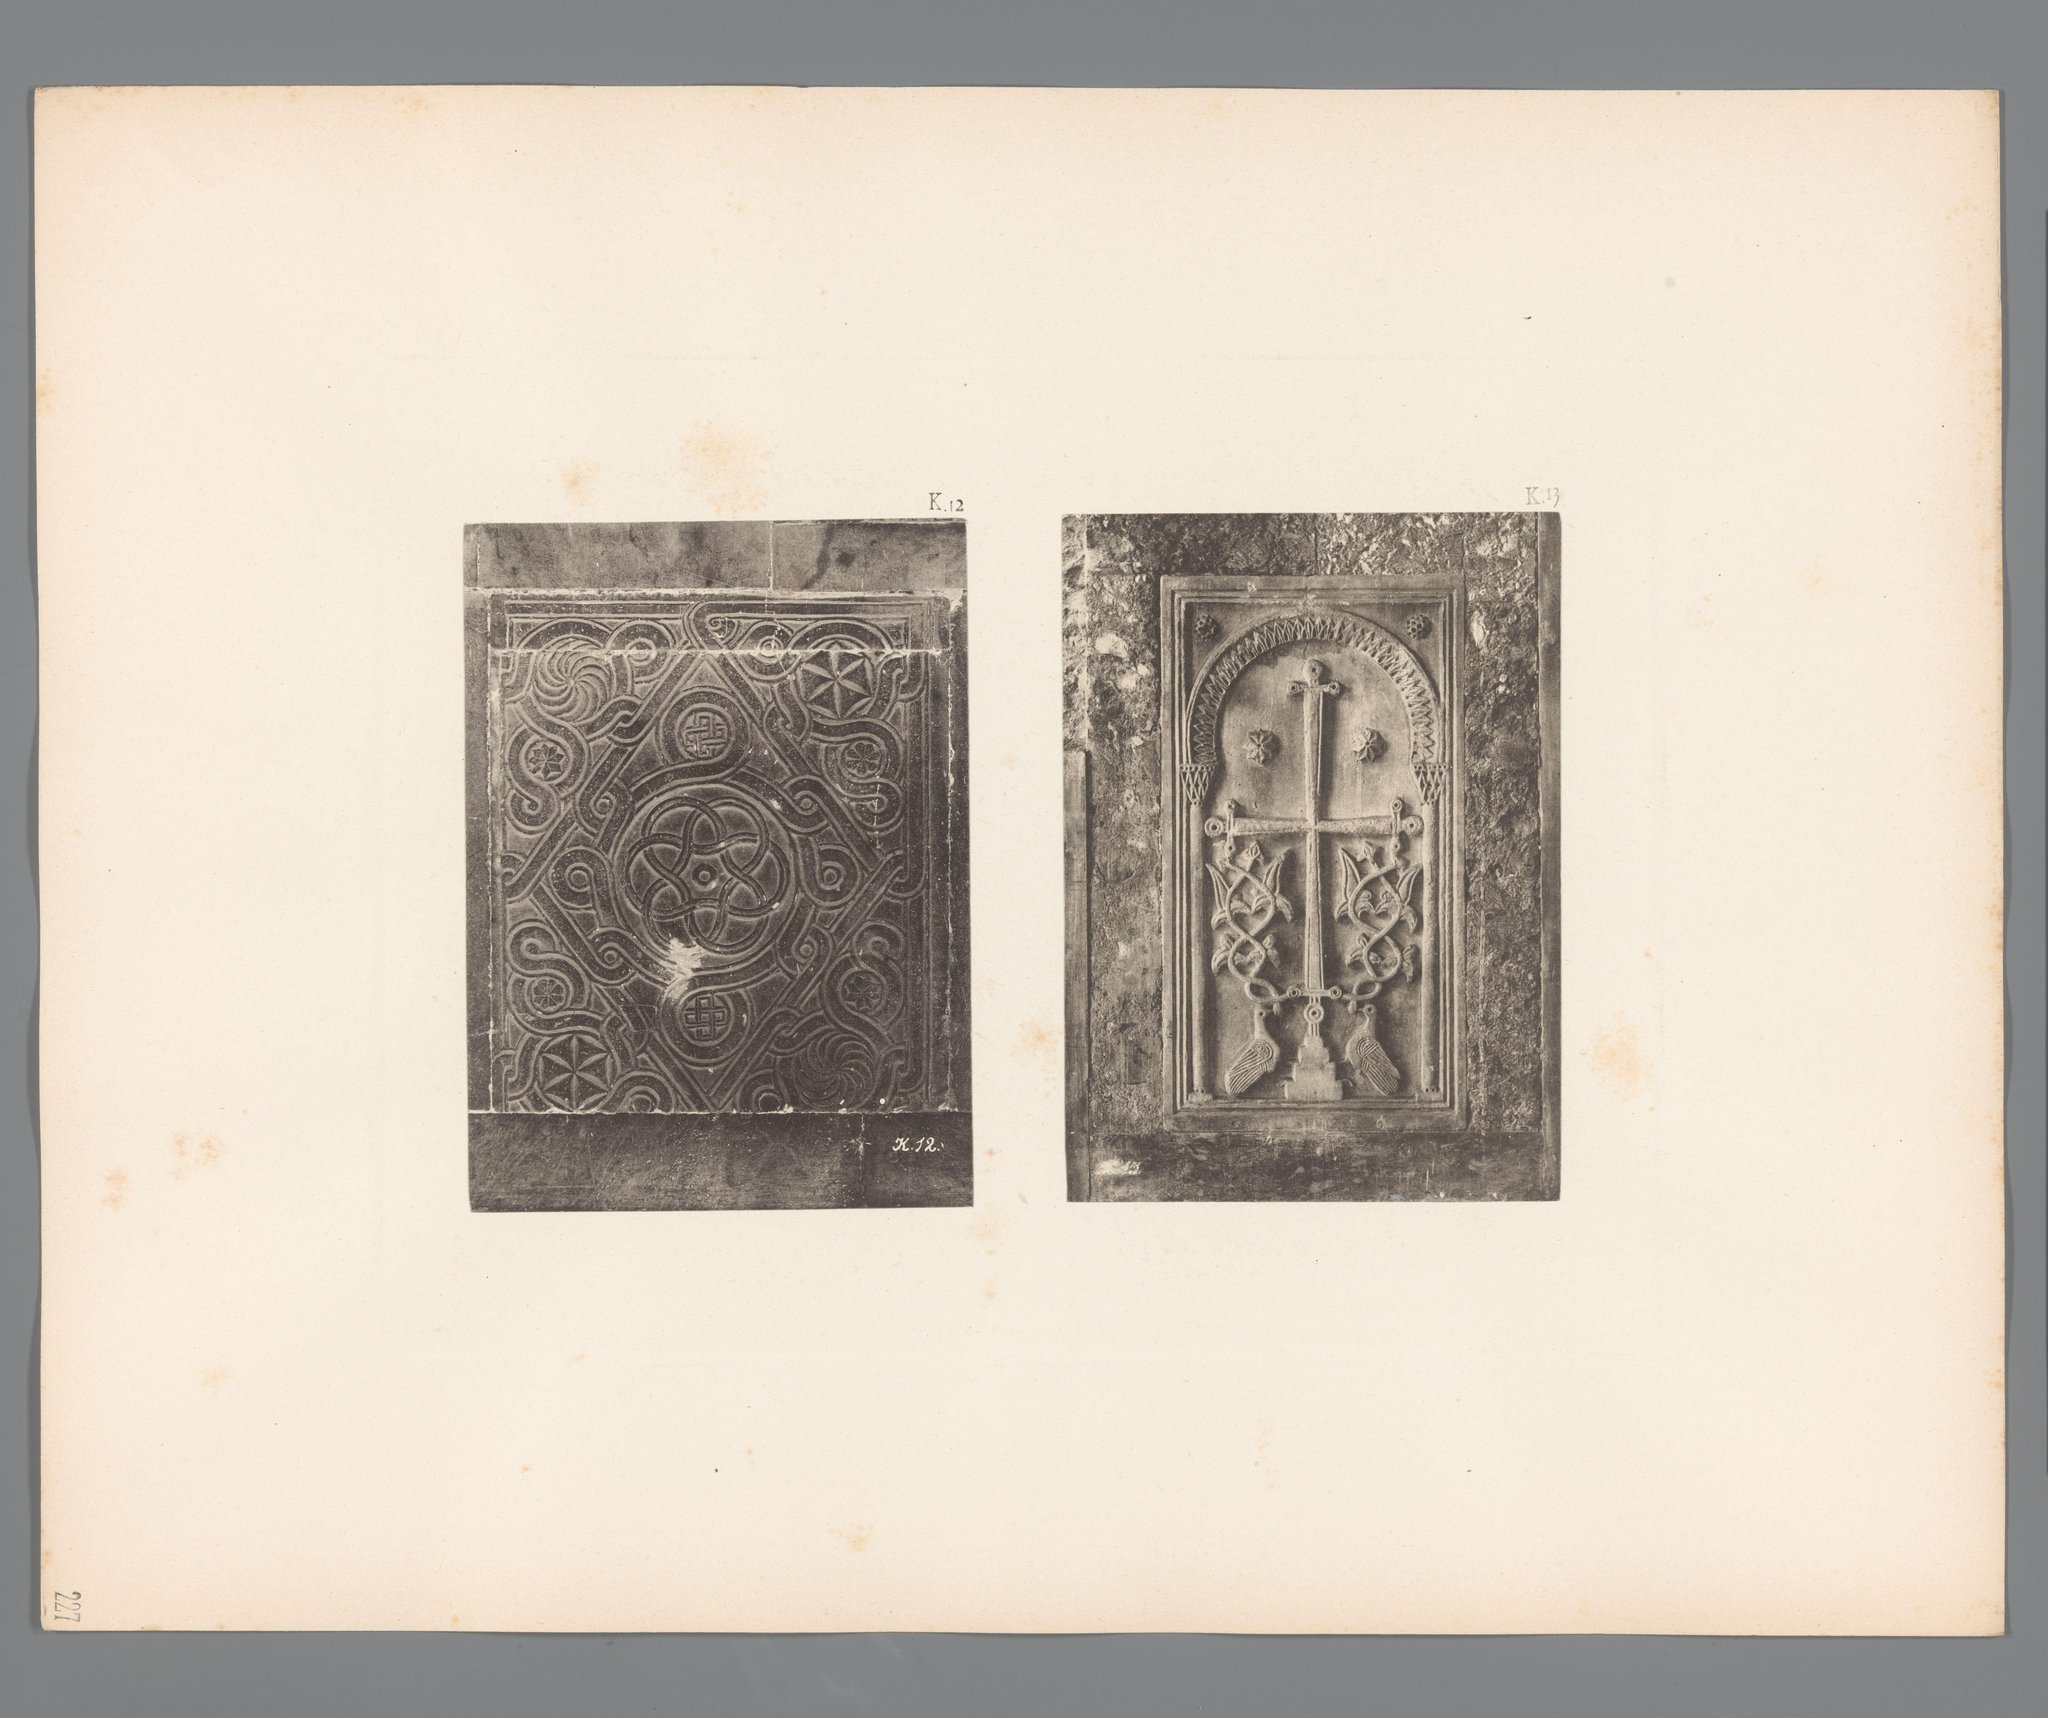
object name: photomechanical print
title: Twee afbeeldingen van details van de San Marco in Venetië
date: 1880-1885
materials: paper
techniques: photograph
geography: venice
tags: the cross ~ symbols of christ, piece of sculpture, reproduction of a piece of sculpture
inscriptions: number: ‘[.]13.’, number: ‘K.12’, number: ‘K.13’, number: ‘227’, number: ‘K.12.’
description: Deze prenten maken deel uit van een omslag met 79 prenten op 53 bladen en 2 tekstbladen.